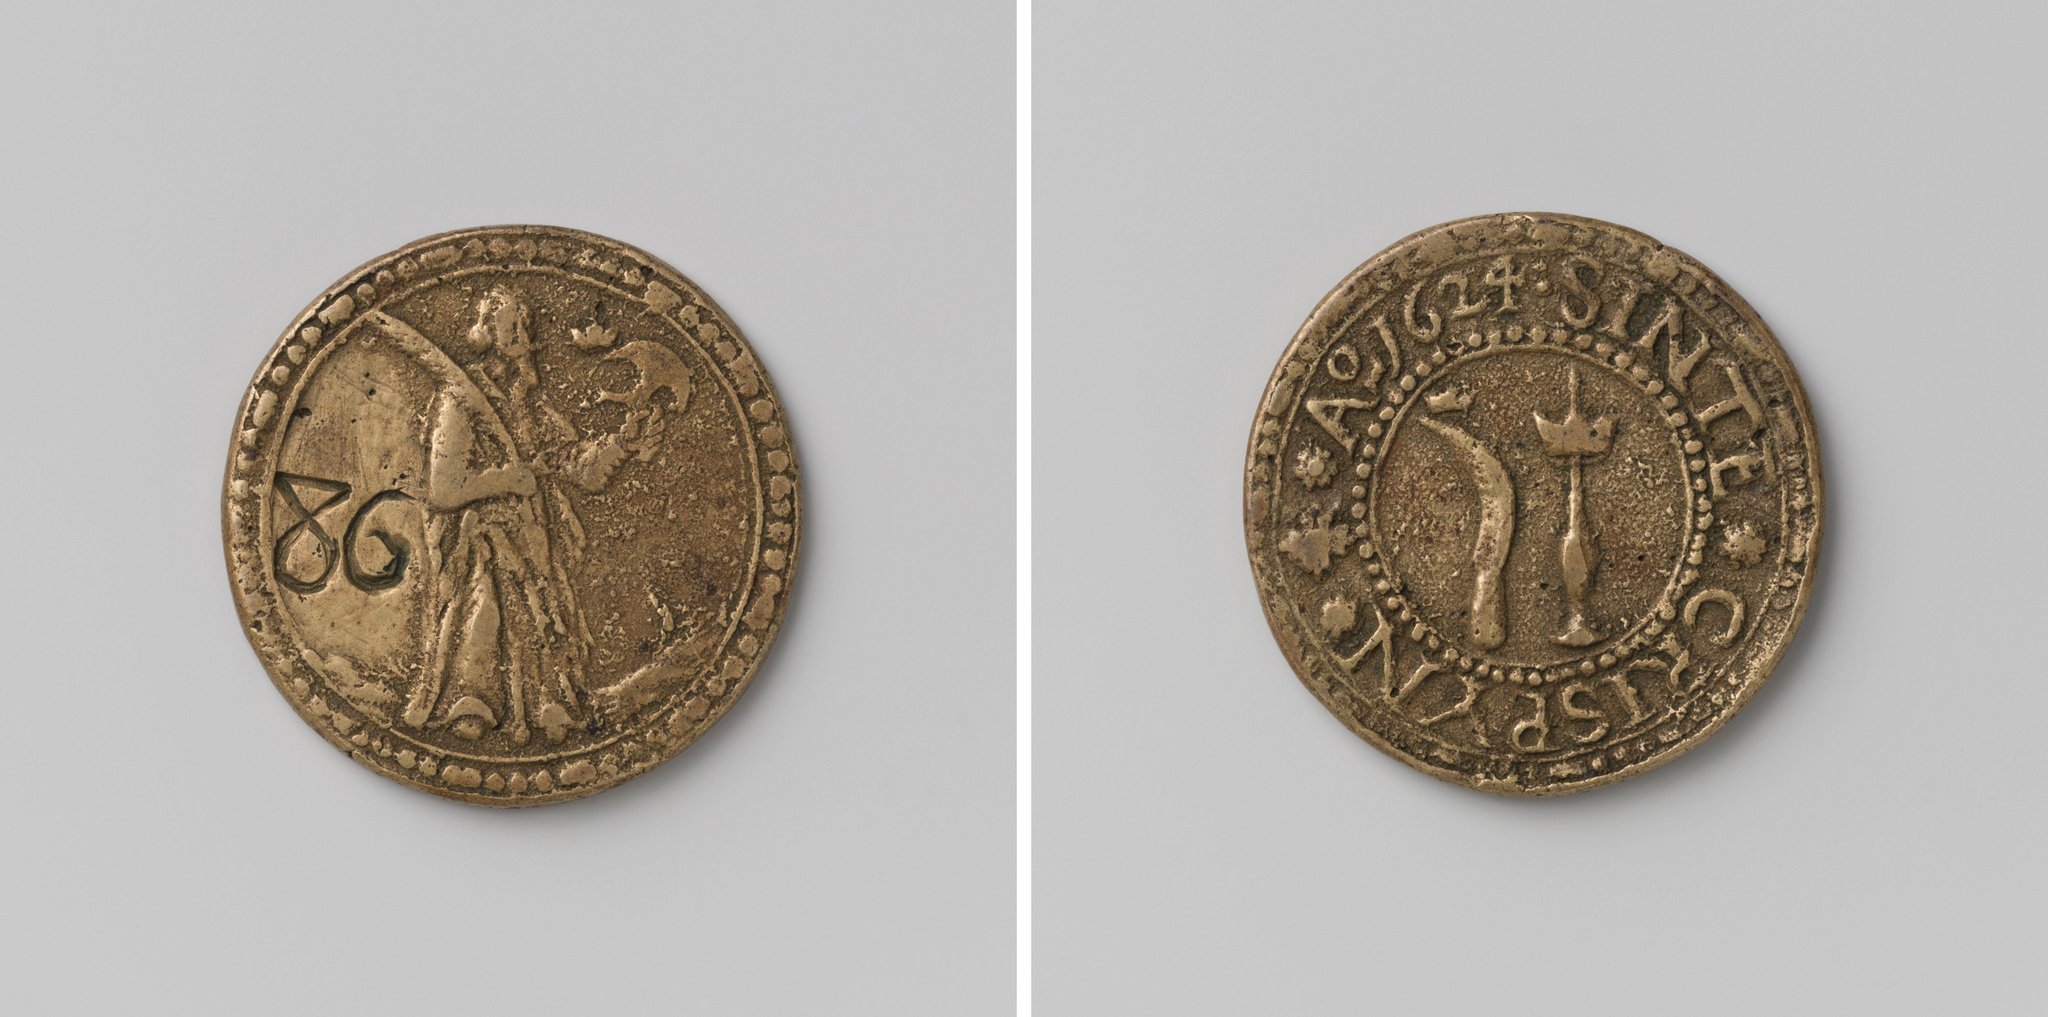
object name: medal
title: St. Crispijn- of schoenmakersgilde van Delft, gildepenning met no. 86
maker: Anonymous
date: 1624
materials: brass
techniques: casting, engraving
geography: delft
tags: delft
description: Messing penning. Voorzijde: rechts gewende St. Crispinus met plamtak in rechter- en schoenmakersmes waarboven kroon zweeft in linkerhand; links boven: cijfer 86. Keerzijde: gekroond krommes naast een door een kroon gestoken els binnen omschrift